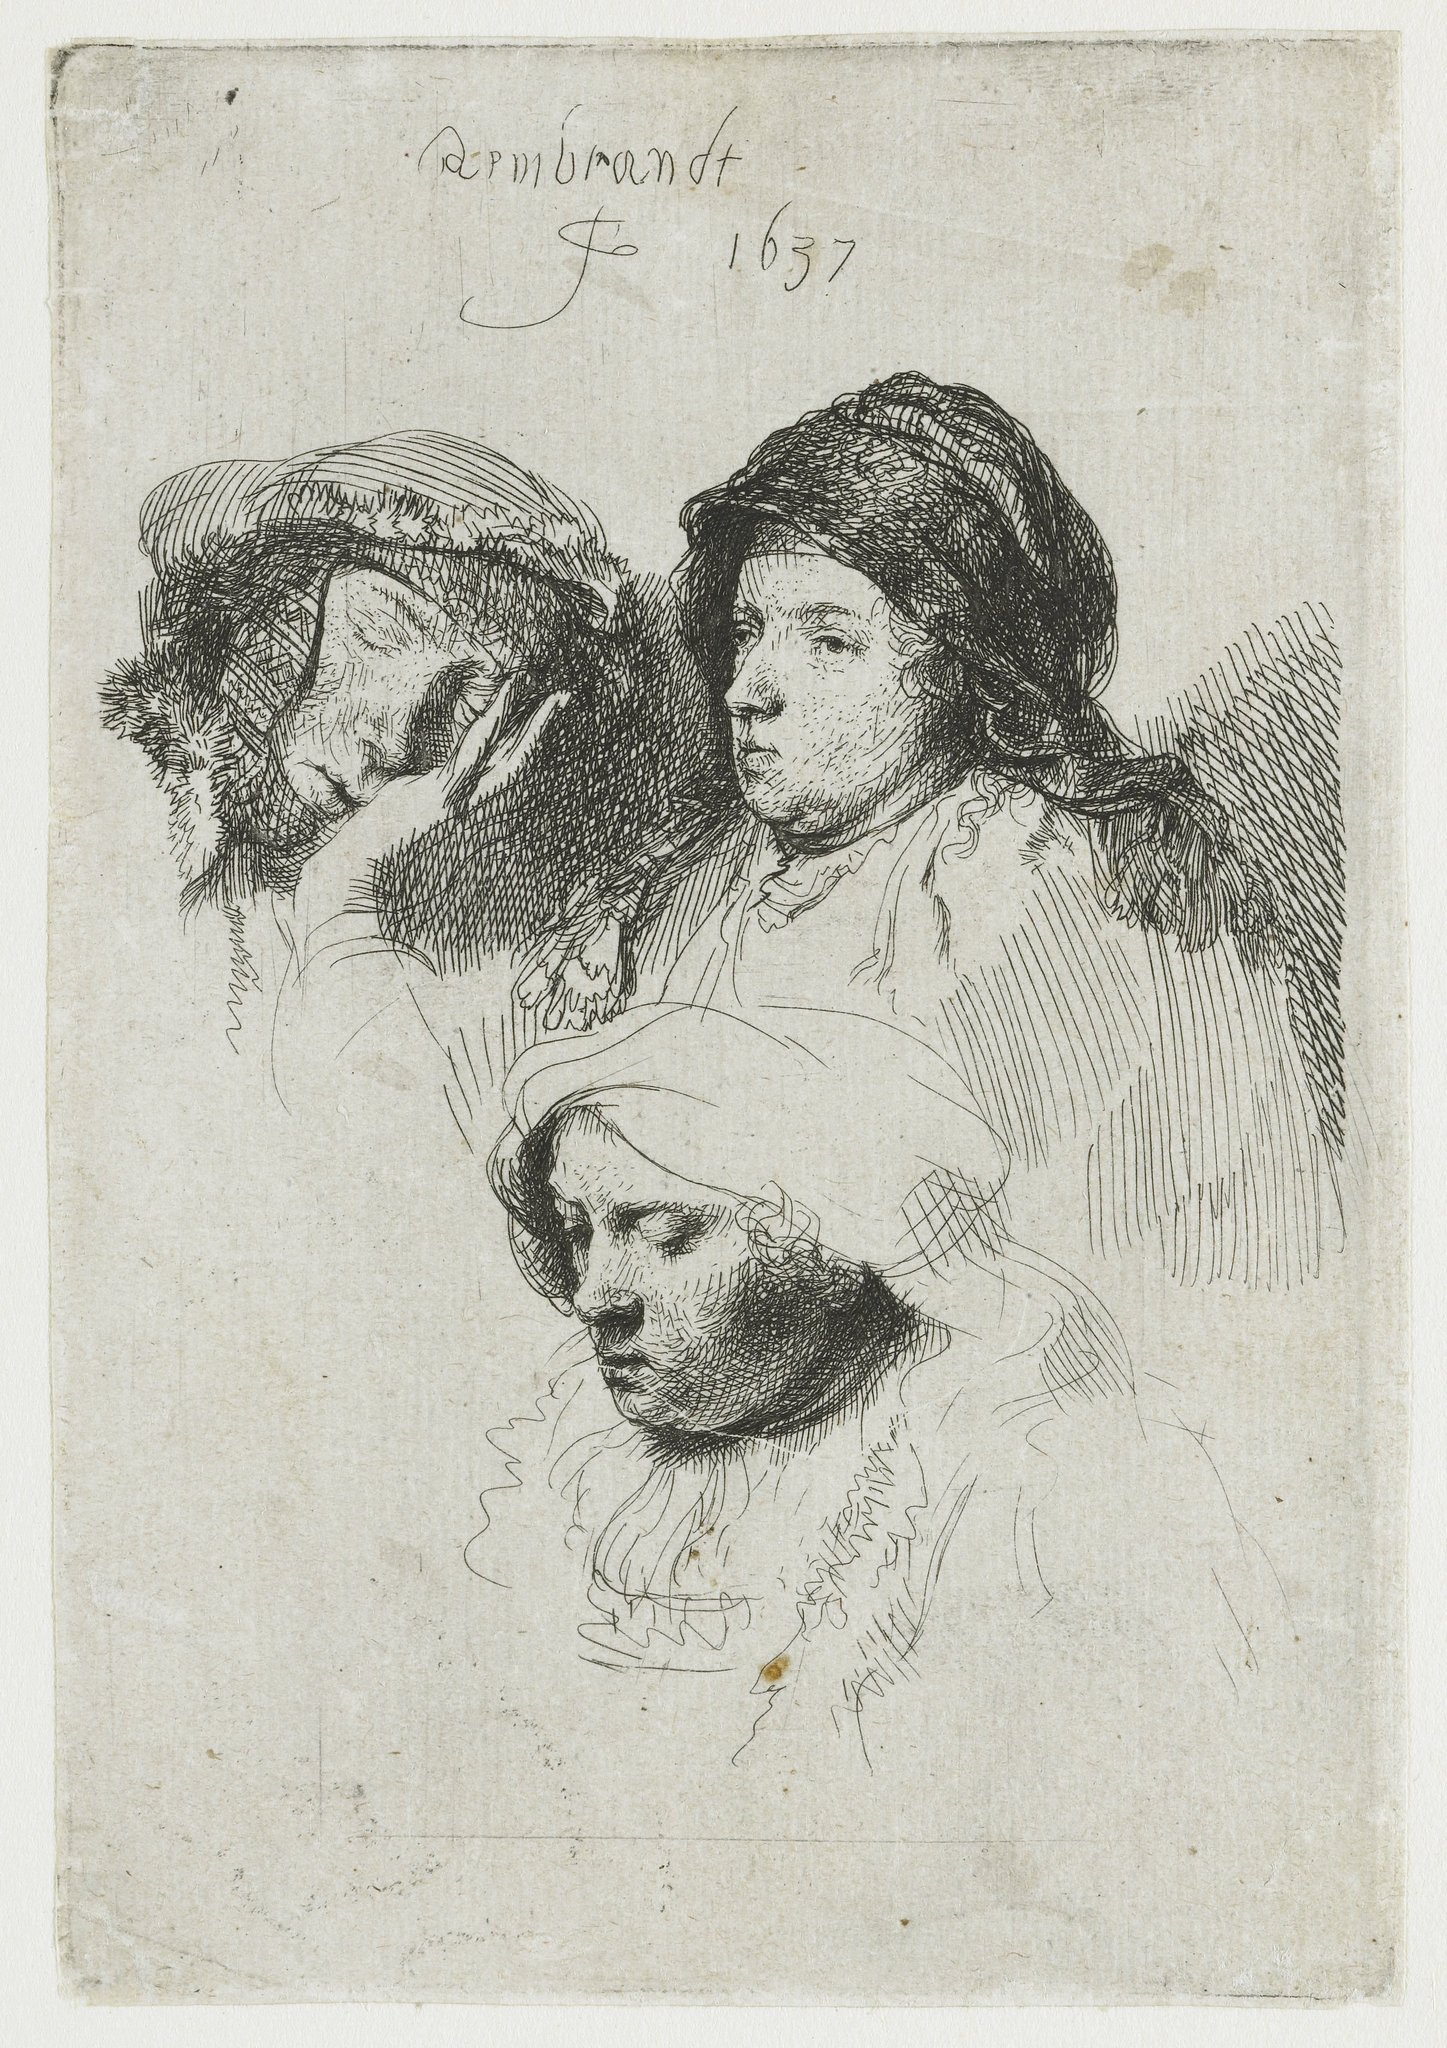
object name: print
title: Three heads of women: one asleep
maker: rembrandt van rijn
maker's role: draughtsman, painter, print maker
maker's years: 1606-1669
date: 1637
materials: paper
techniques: etching, intaglio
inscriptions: collector's mark: Lugt 240, signature and date: ‘Rembrandt f 1637’